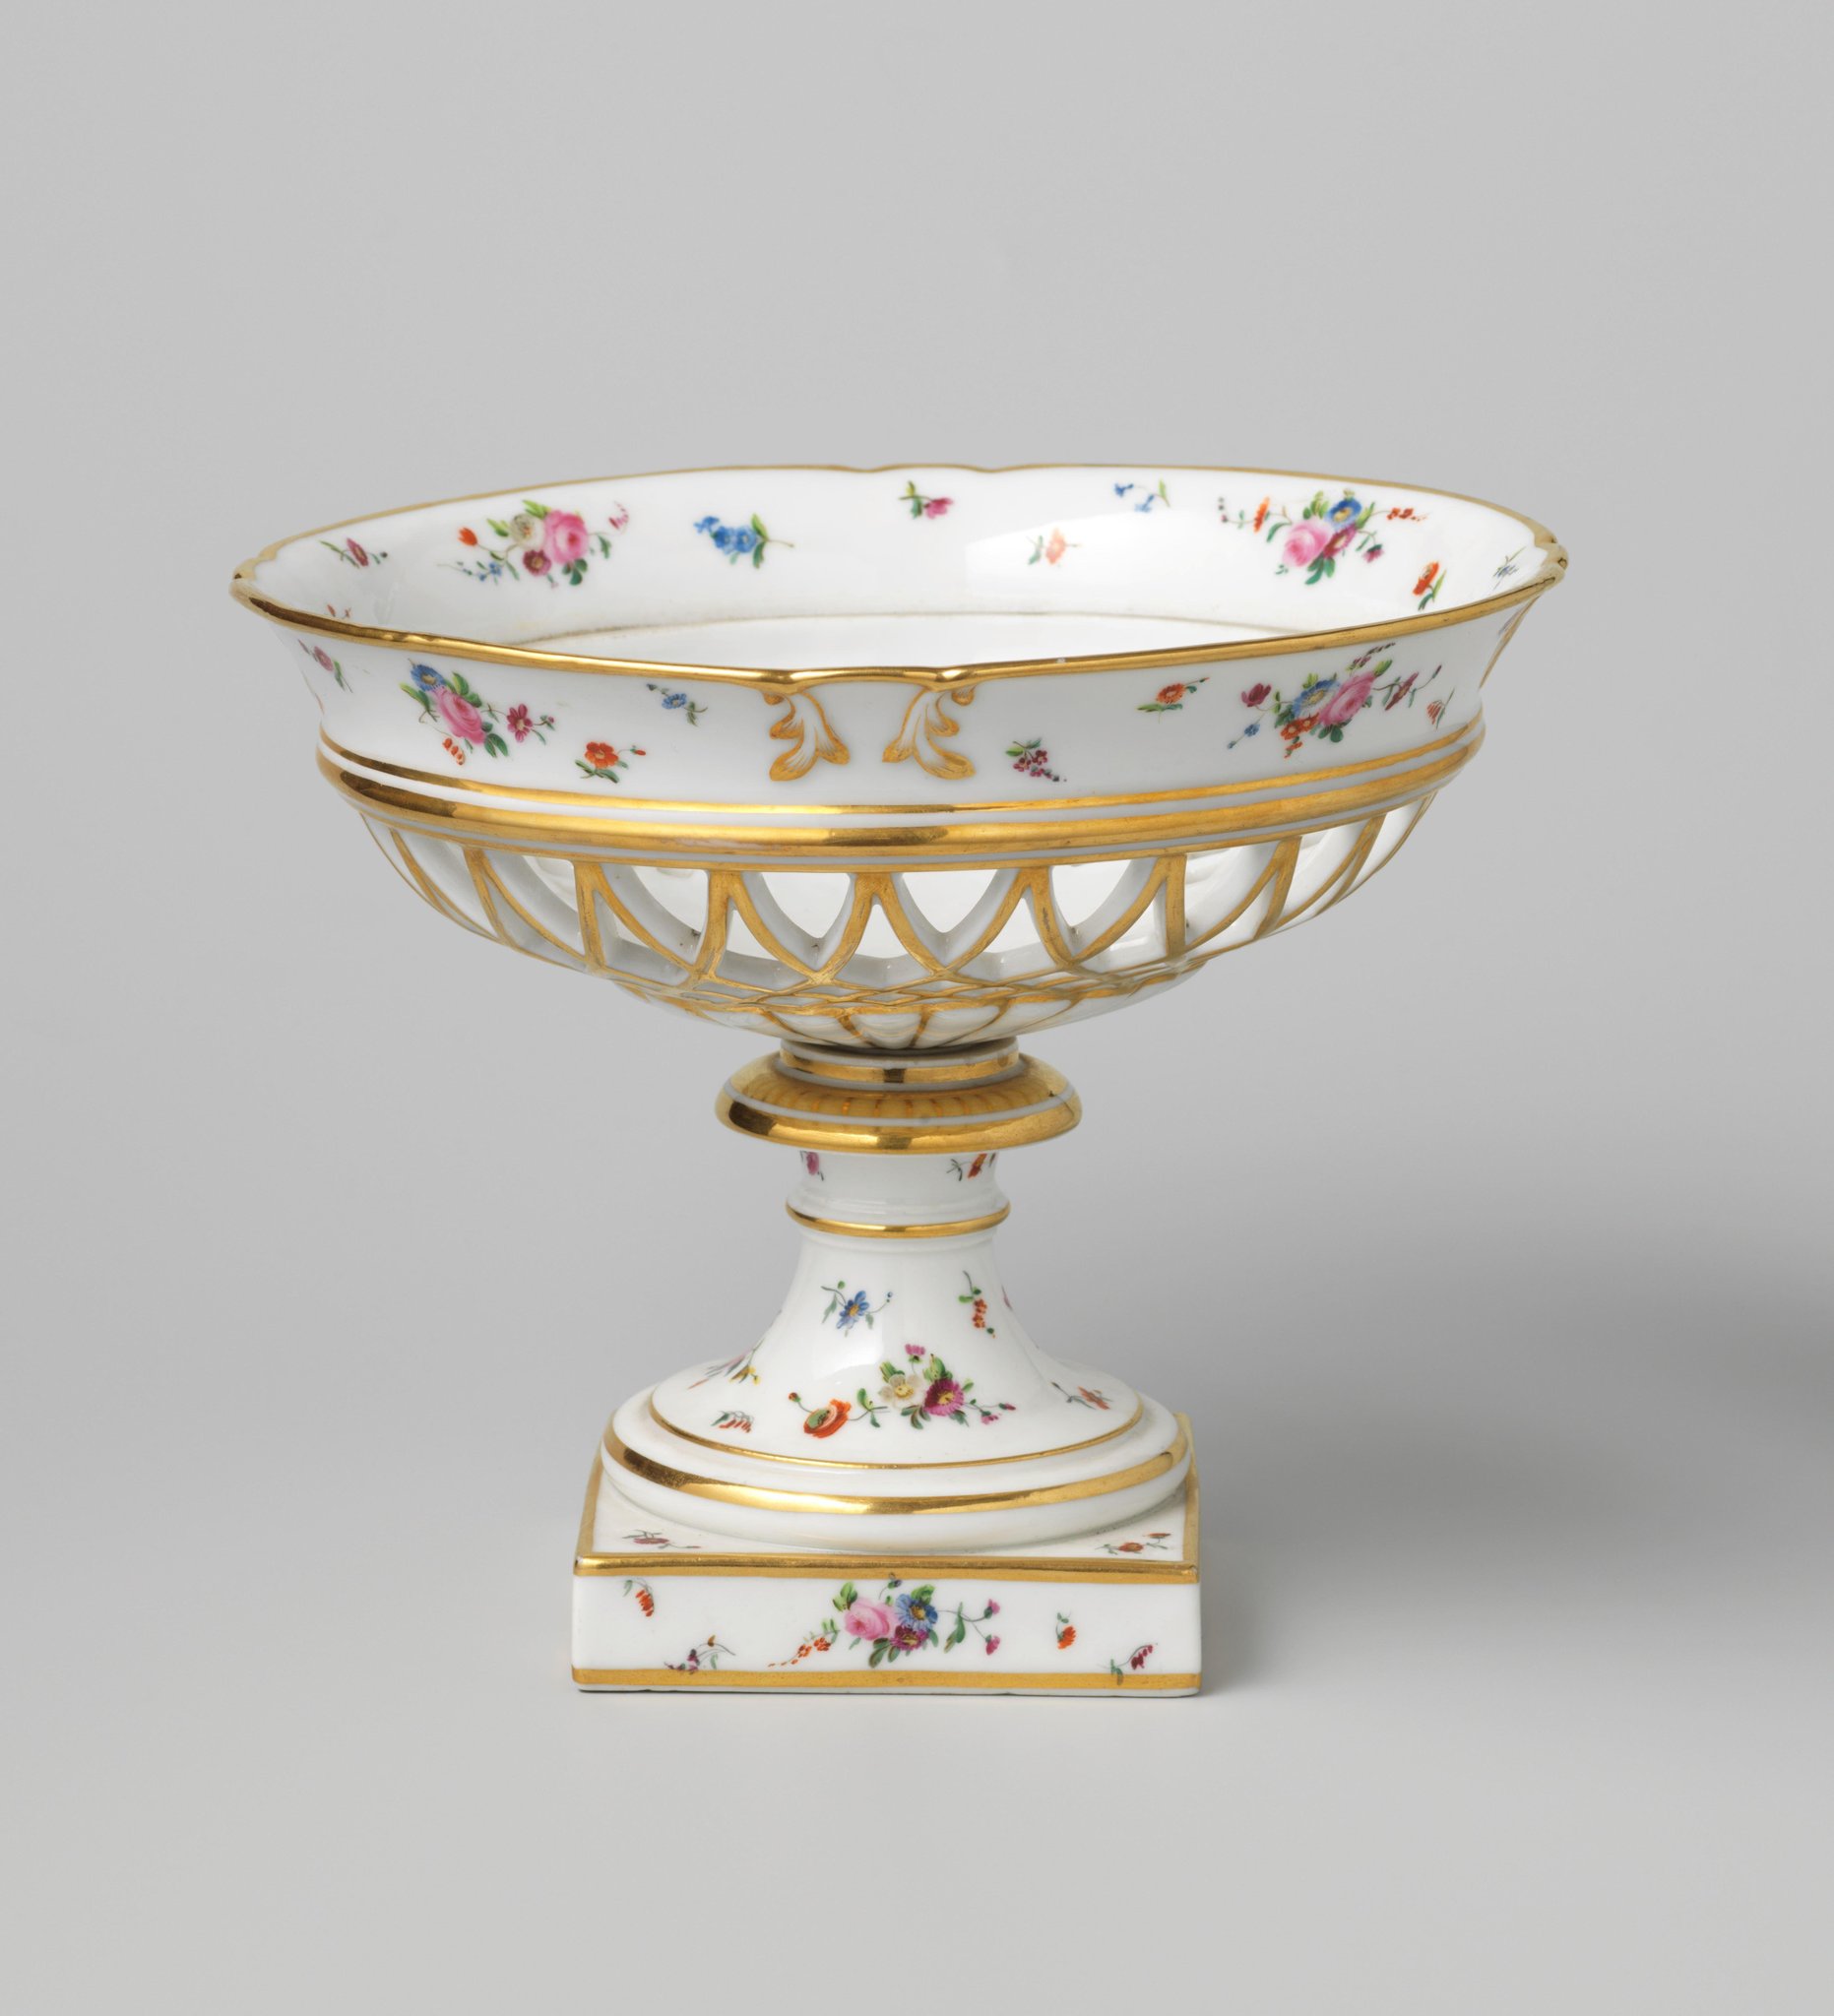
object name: fruit bowl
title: Dish with bouquets and flower sprays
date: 1839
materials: glaze, gold, paint, porcelain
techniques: embroidery, firing, forming, gilding, turning, vitrification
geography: paris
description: Schaal (fruitschaal) van porselein met een gelobde rand, beschilderd op het glazuur in blauw, rood, roze, groen, geel, paars, zwart en goud. Het onderste deel van de wand is opengewerkt. Versierd met boeketten van verschillende bloemen, strooibloemen en gouden lijnen. Vanuit de gelobde, gouden rand, gemodelleerde bladranken op de buitenwand, aangezet met goud.